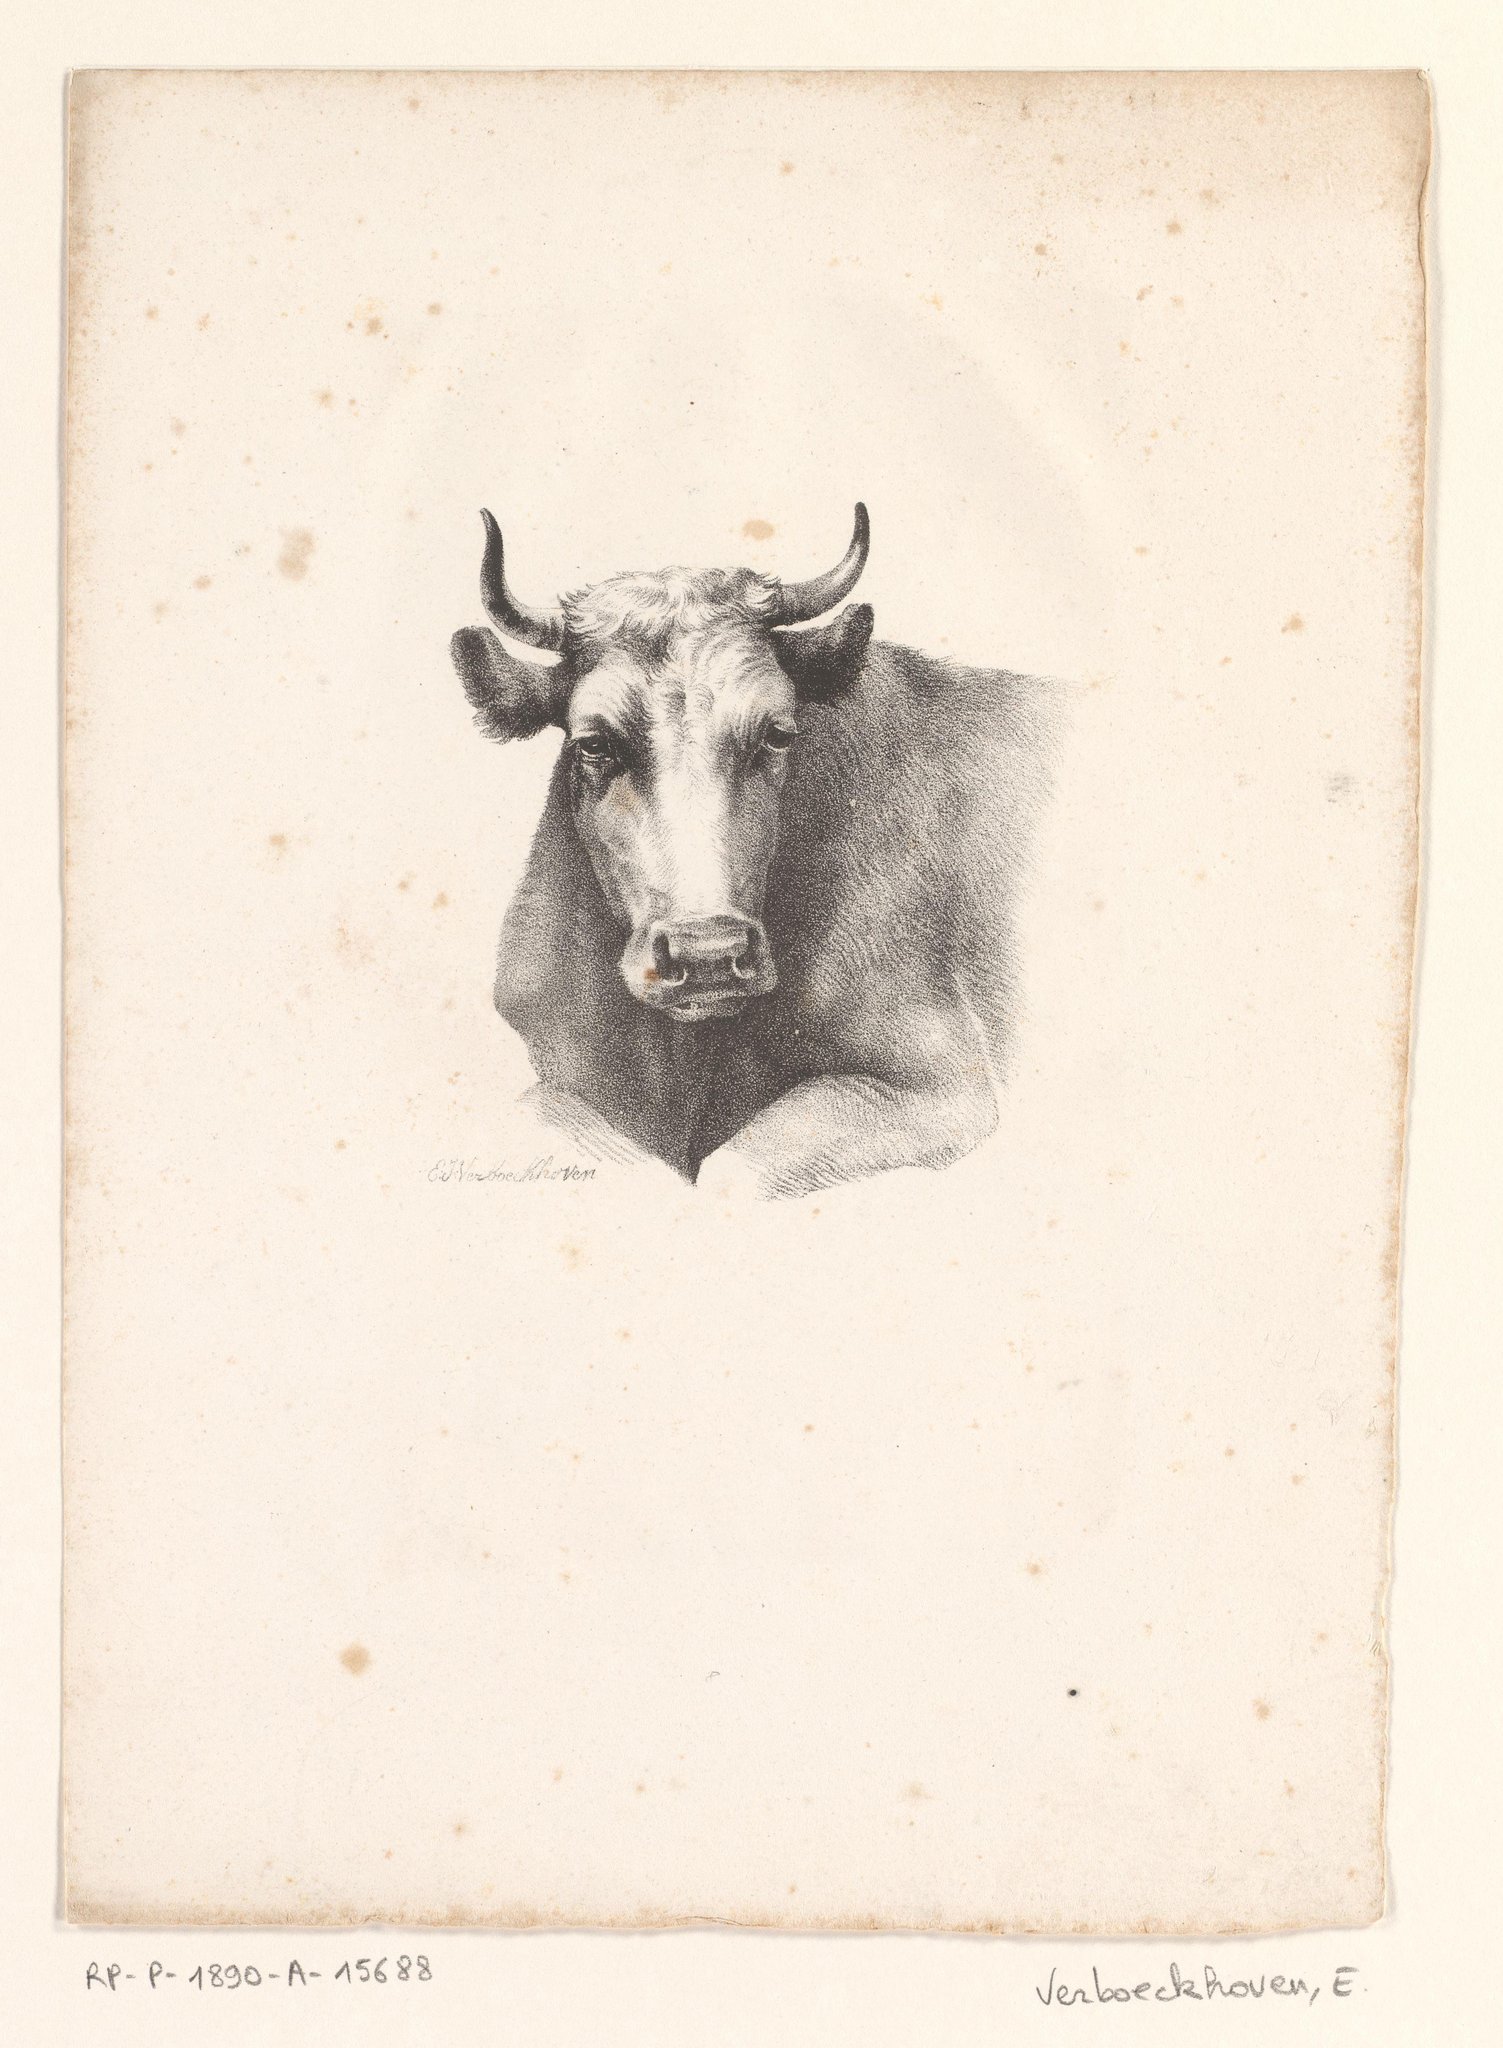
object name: print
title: Kop van een liggende koe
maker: eugène verboeckhoven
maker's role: draughtsman, painter, print maker, printer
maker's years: 1798-1881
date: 1808-1881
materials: paper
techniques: lithograph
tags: cow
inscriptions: collector's mark: Lugt 2228